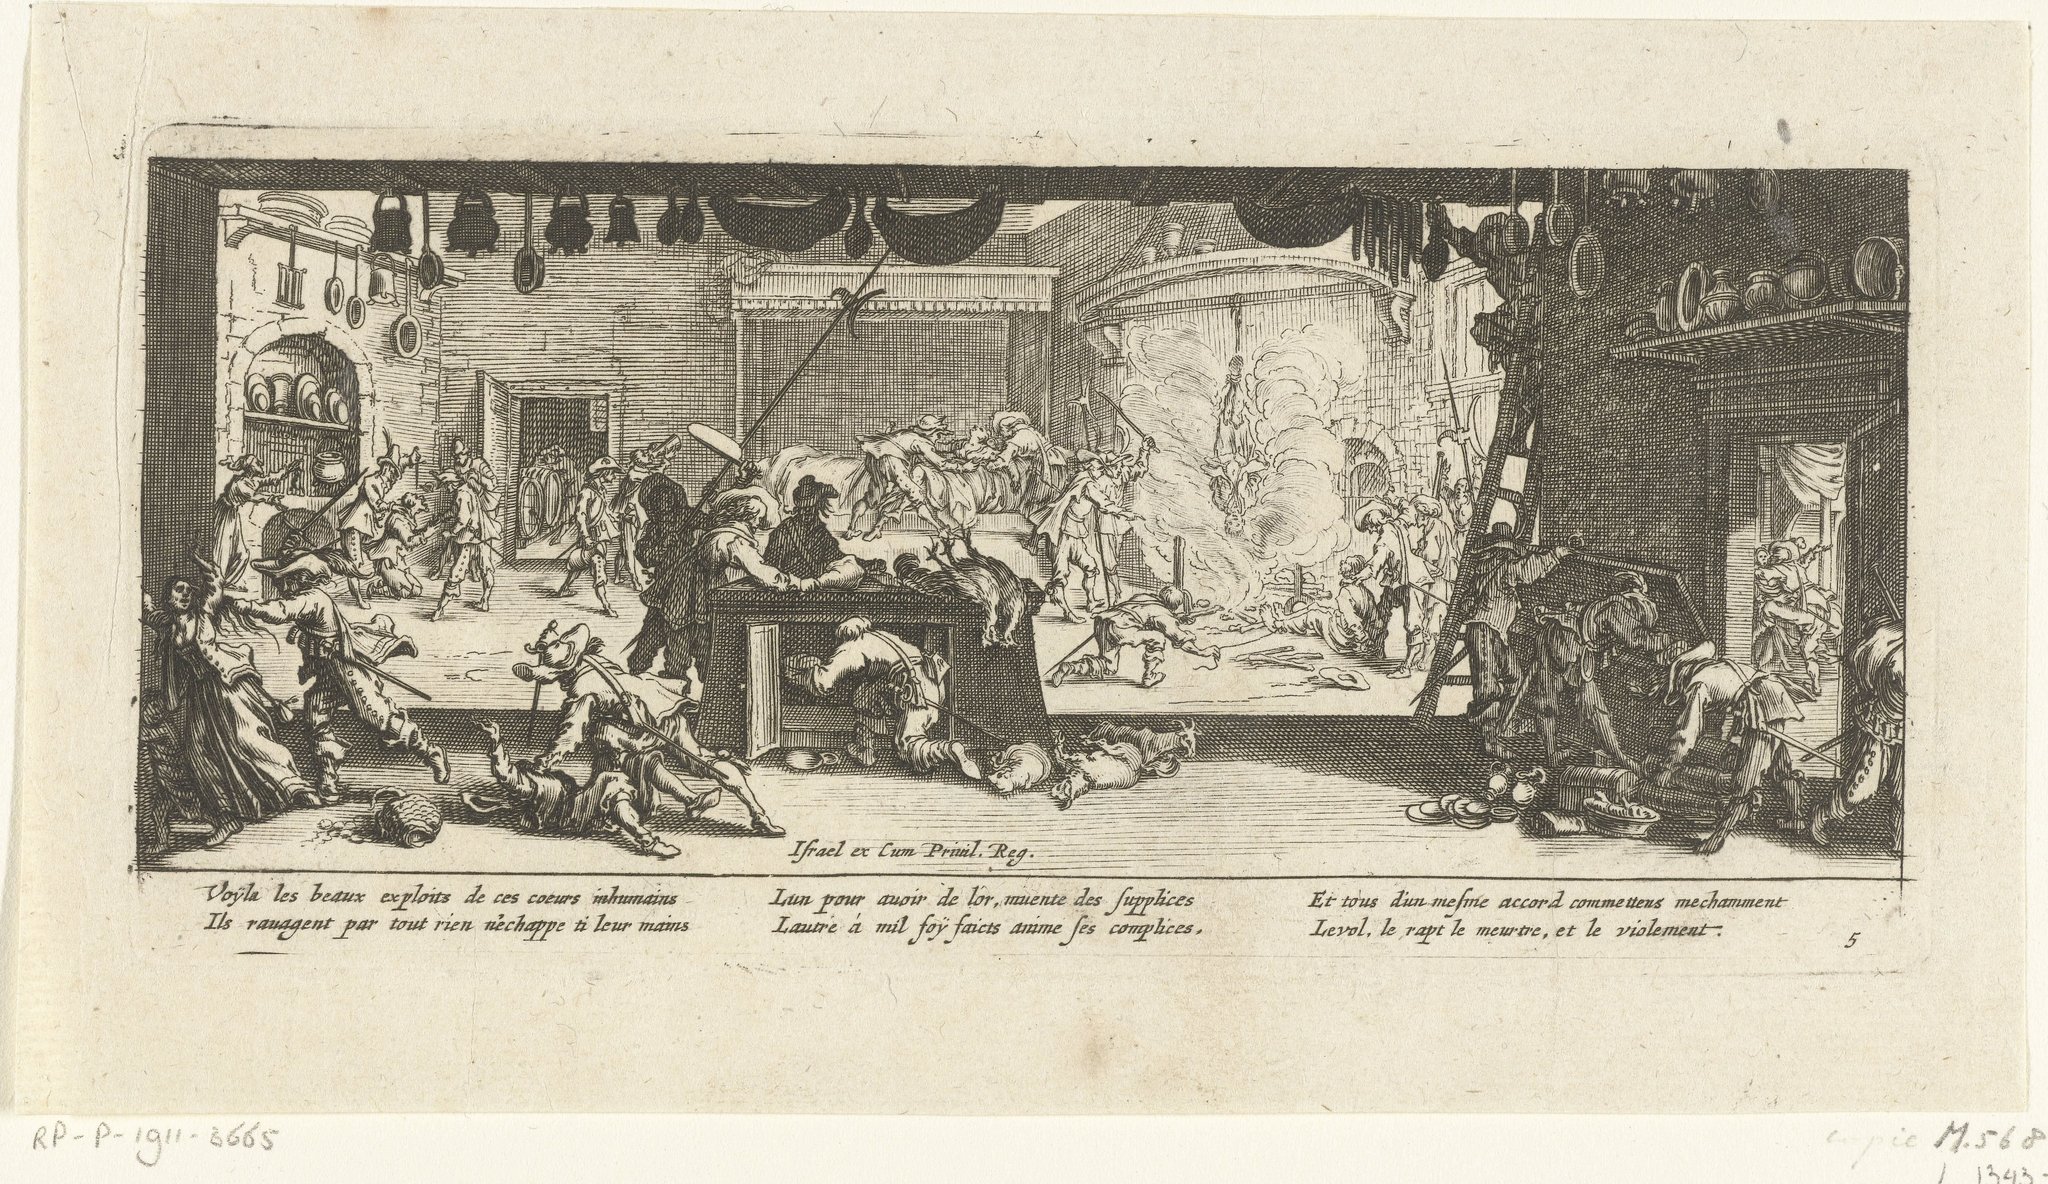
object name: print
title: Soldaten plunderen een boerderij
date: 1677-1690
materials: paper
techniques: etching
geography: netherlands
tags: plundering ~ soldiers, soldiers and civilians, fighting, farm (building) - aa - civic architecture: inside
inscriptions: collector's mark: Lugt 2228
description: Soldaten martelen, verkrachten en vermoorden de inwoners van een boerderij, en roven hun goederen en etenswaren. Onder de voorstelling een zesregelig Frans vers. Deze prent is onderdeel van een serie van 17 (18 incl. titelprent) prenten met voorstellingen van diverse soorten ellende die oorlogvoering met zich meebrengt.